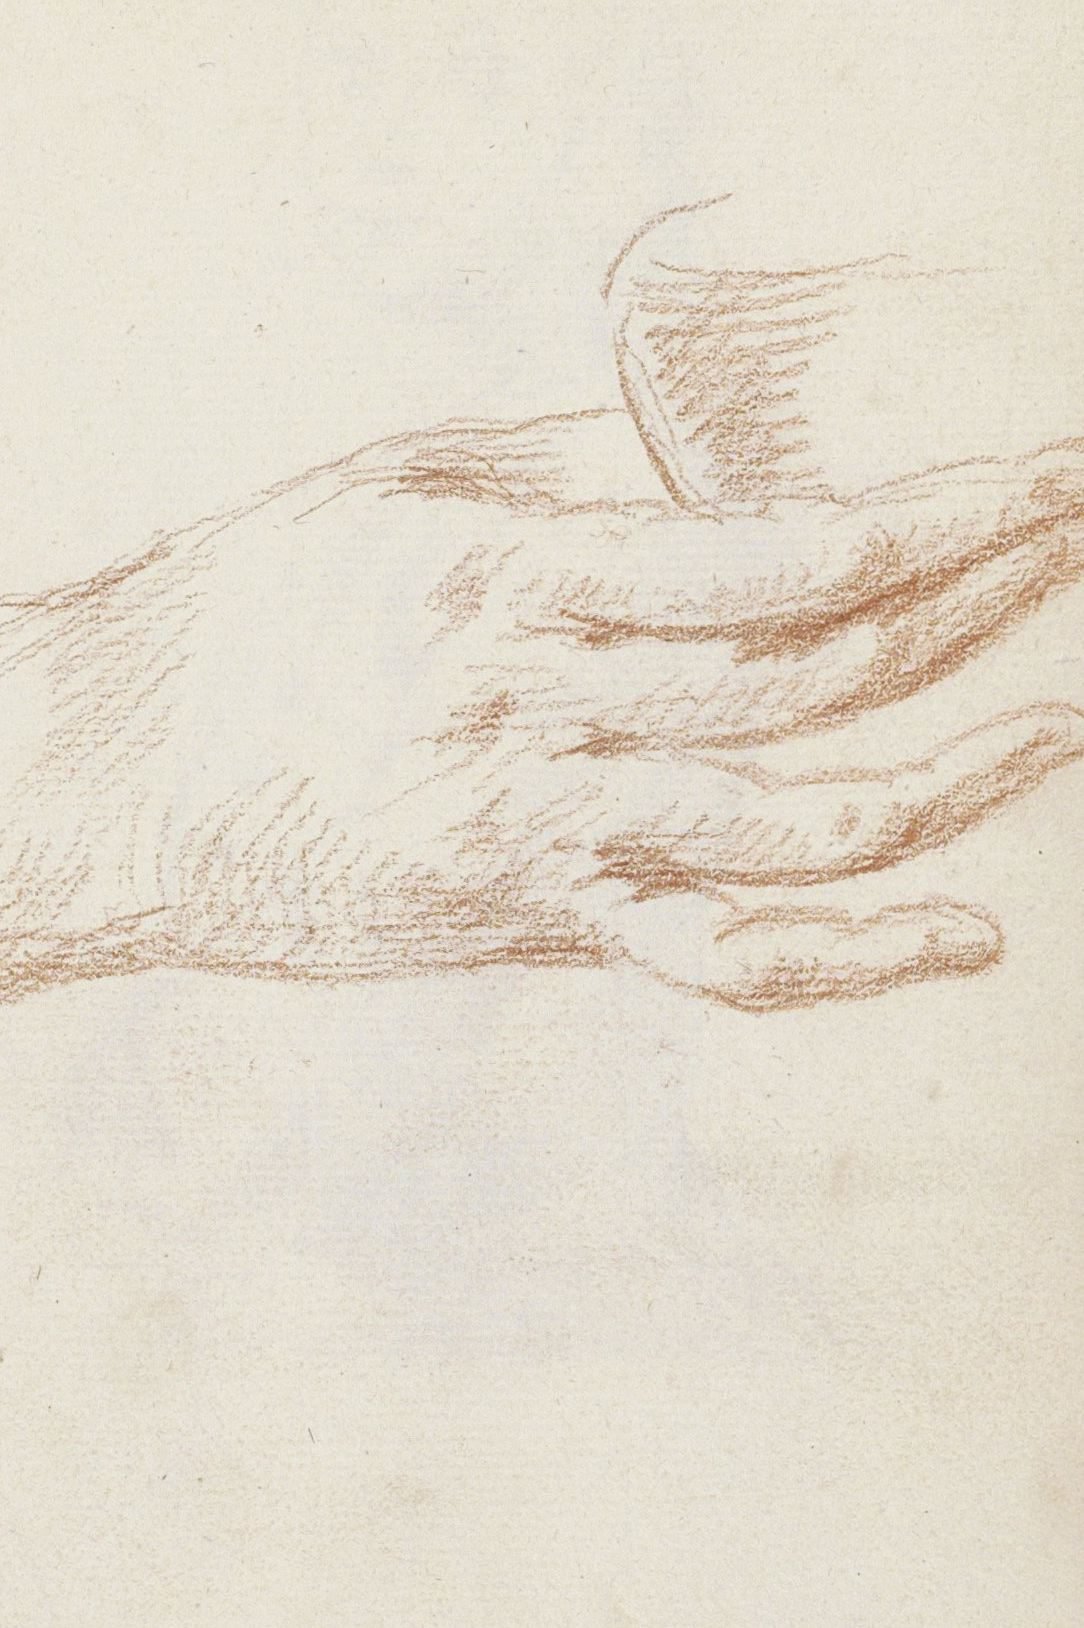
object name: sketchbook leaf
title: Hand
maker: petrus johannes van reysschoot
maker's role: draughtsman, print maker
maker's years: 1702-1772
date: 1710-1772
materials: chalk, paper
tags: hand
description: De hand houdt vermoedelijk de knop van een (wandel)stok vast. Blad 55 recto uit een schetsboek met 105 bladen.